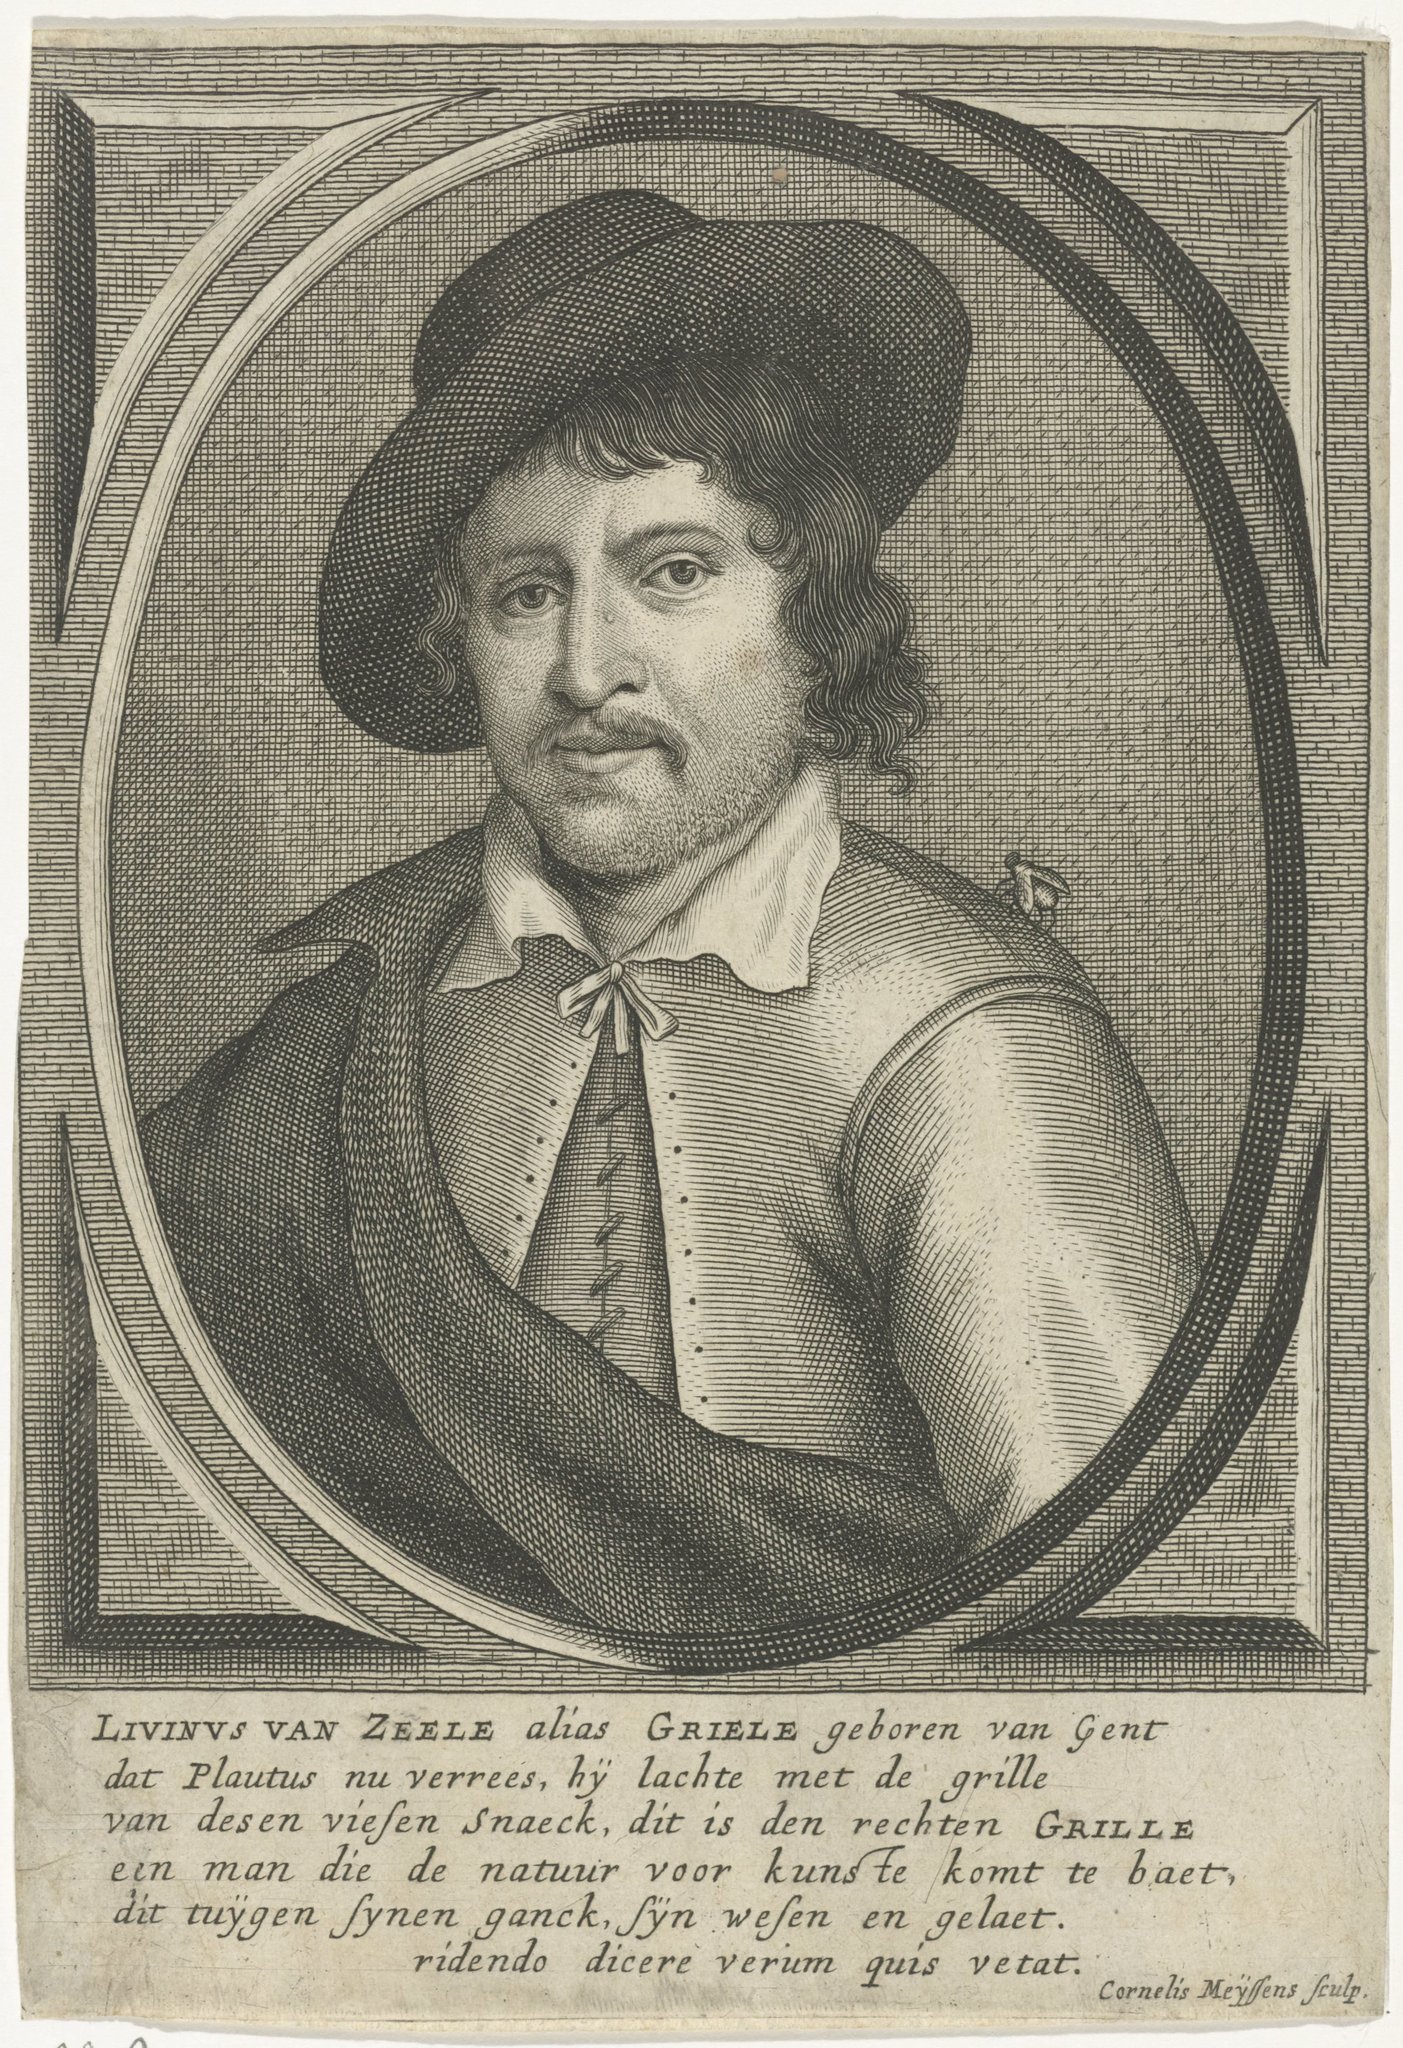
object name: print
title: Portret van Livinus van Zeele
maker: cornelis meyssens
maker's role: print maker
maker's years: 1640-1673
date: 1650-1660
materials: paper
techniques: engraving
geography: antwerp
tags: ghent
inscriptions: collector's mark: Lugt 2228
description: Portret van Livinus van Zeele, toneelschrijver, met een hoed op zijn hoofd.